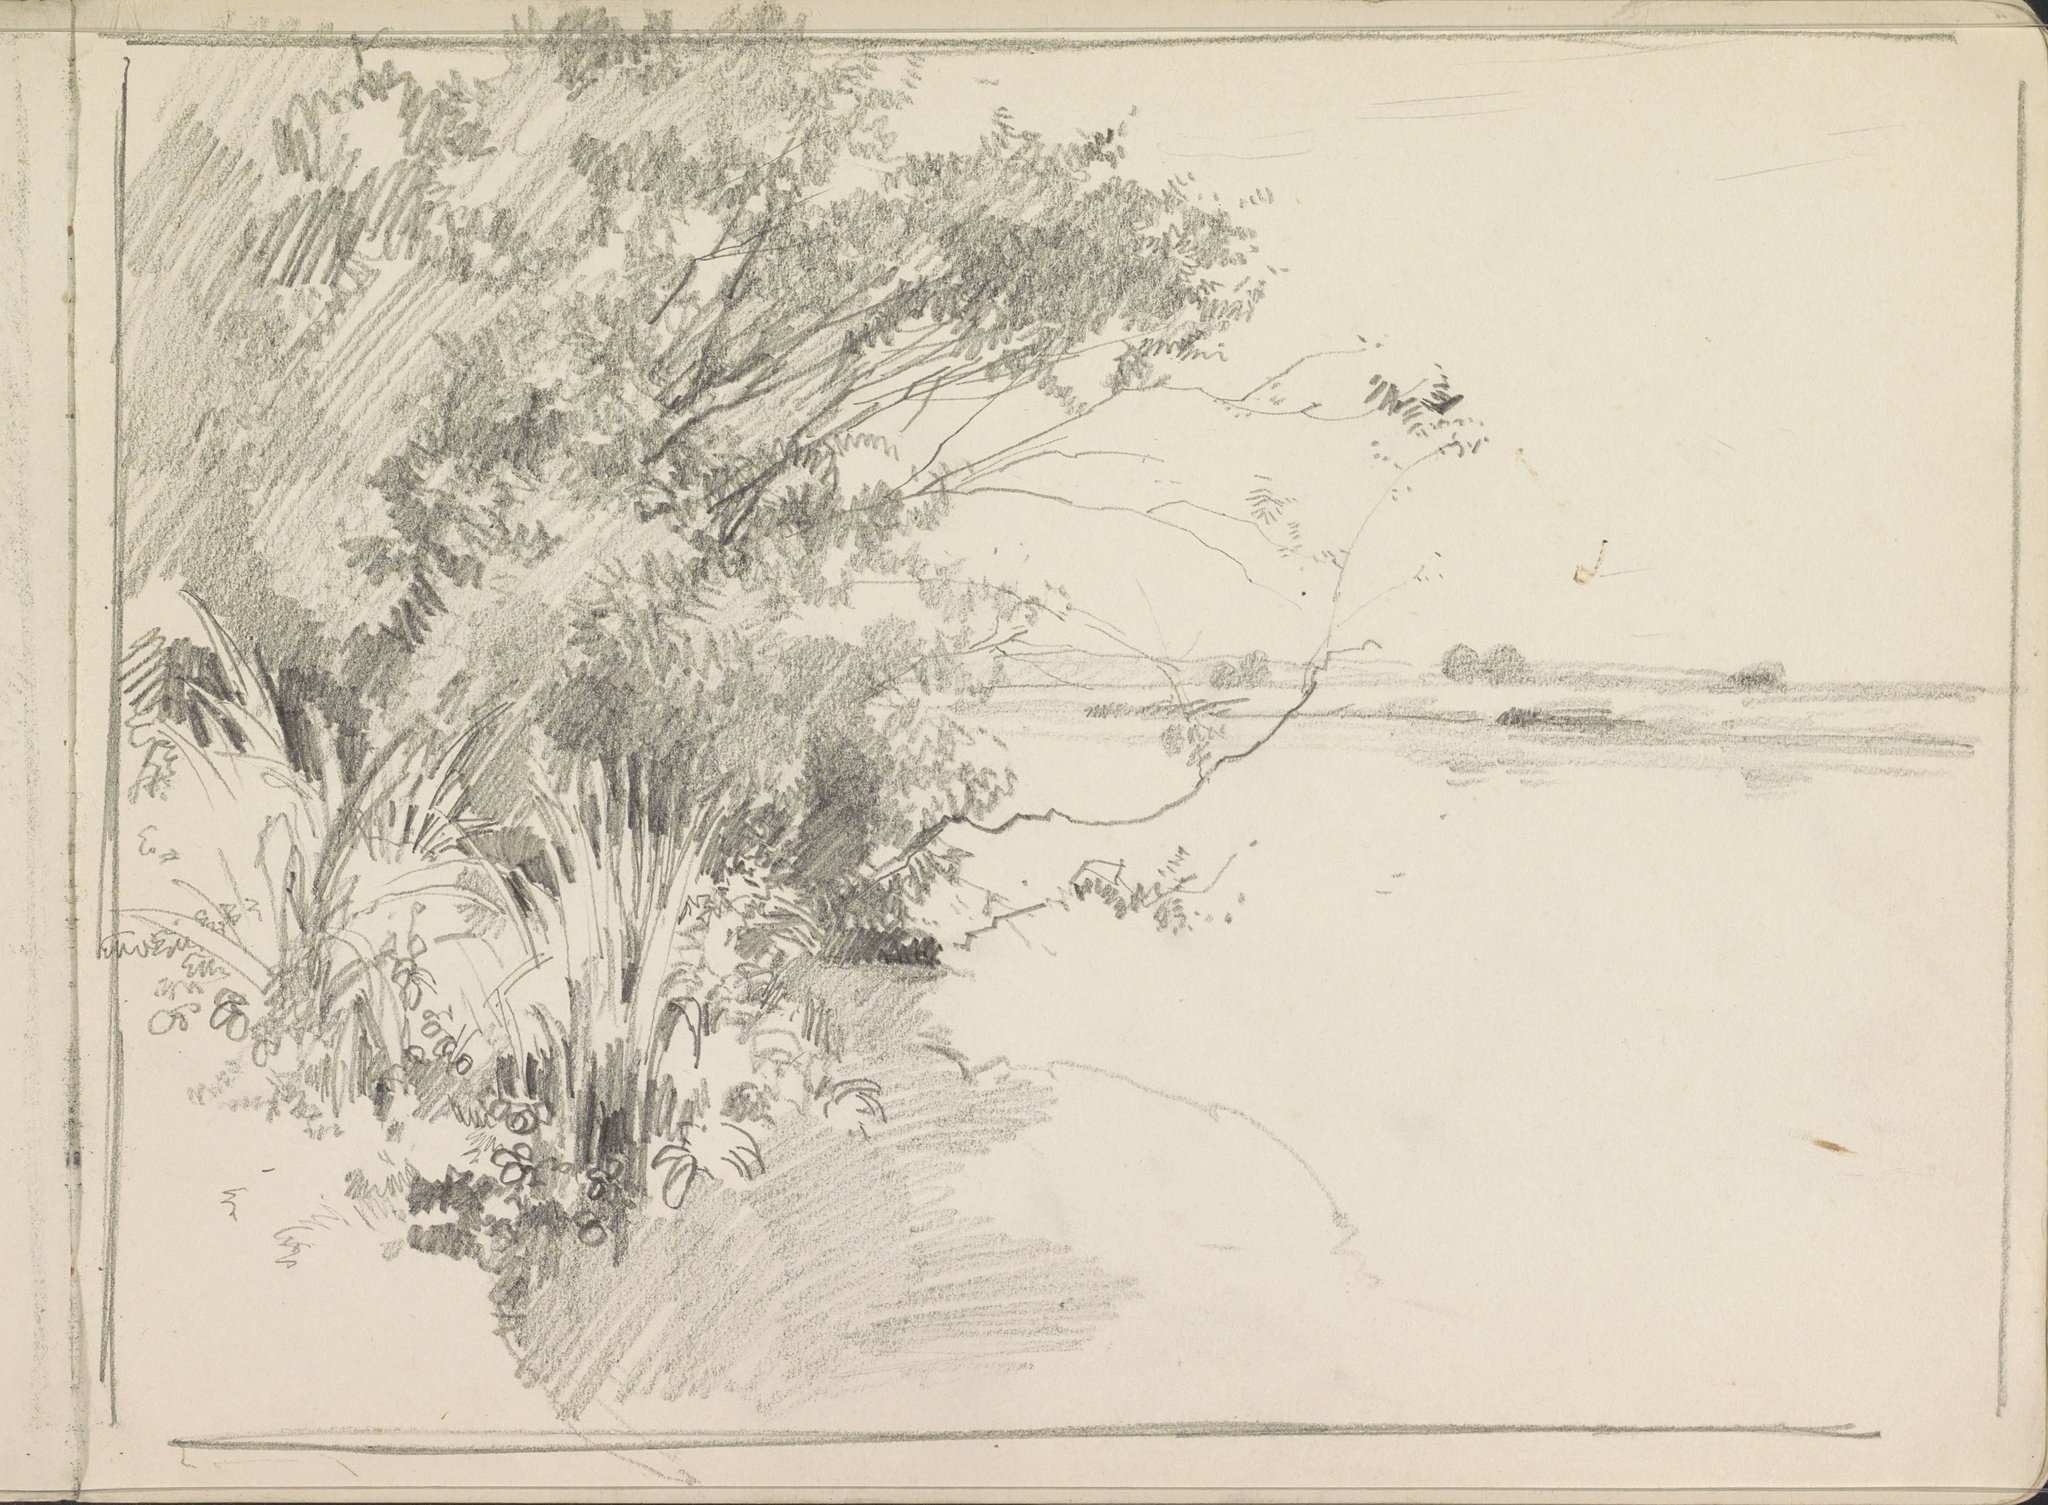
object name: sketchbook leaf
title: Landschap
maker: cornelis vreedenburgh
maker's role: draughtsman, print maker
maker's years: 1880-1946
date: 1890-1946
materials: paper, pencil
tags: landscapes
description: Blad 4 recto uit een schetsboek met 23 bladen.